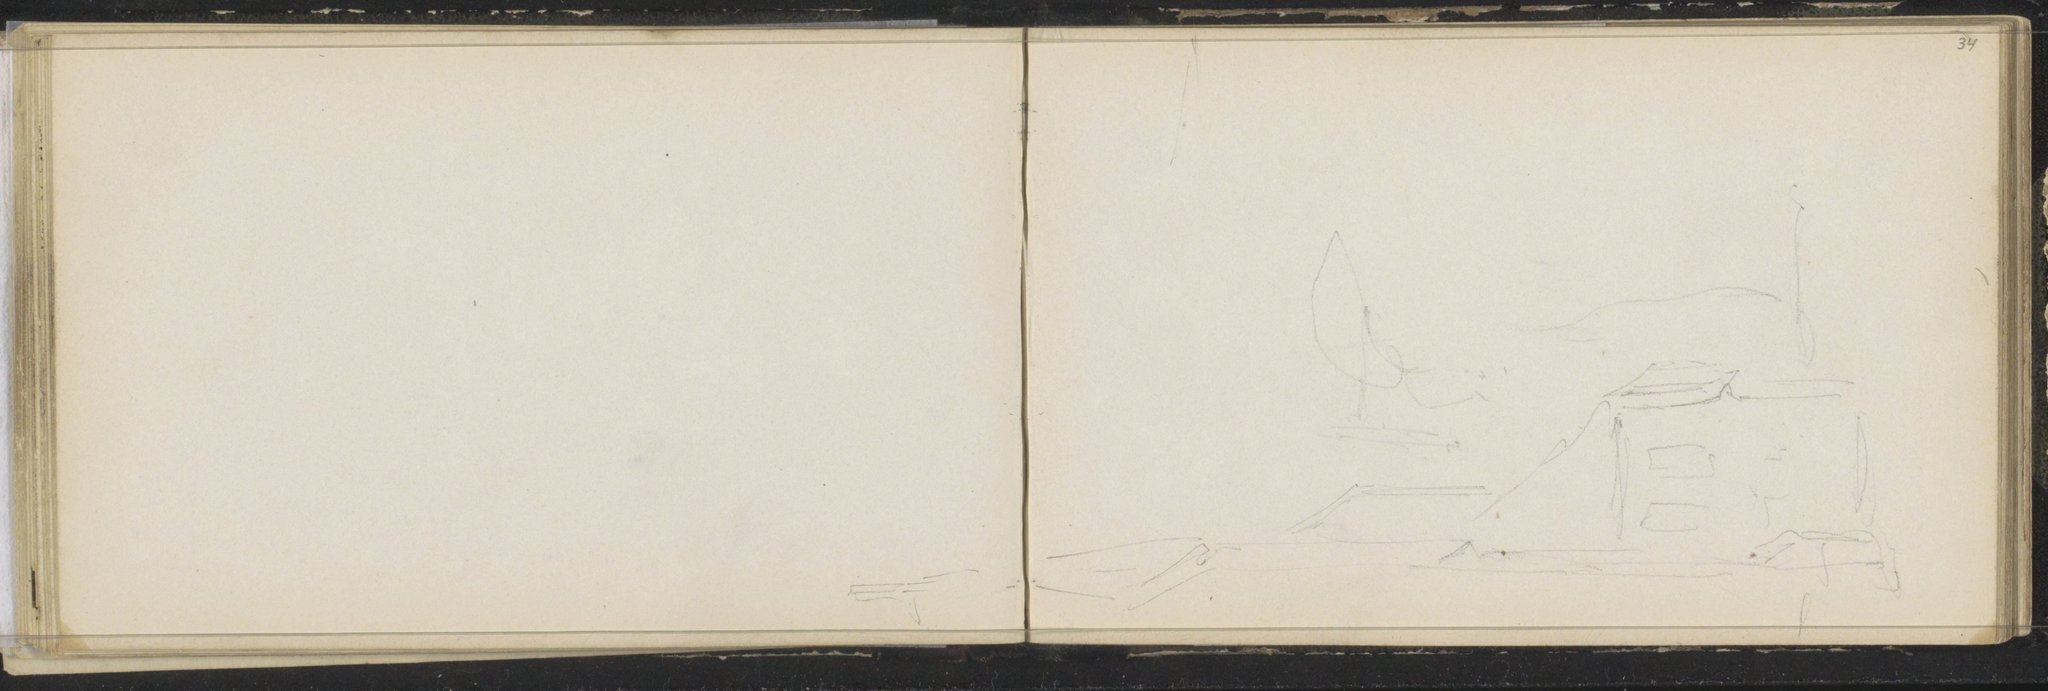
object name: sketchbook leaf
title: Gezicht op gebouwen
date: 1863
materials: paper, pencil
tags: urban housing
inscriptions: annotation: ‘dito voor honden’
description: Gezicht op gebouwen. Blad 33 verso en blad 34 recto uit een schetsboek met 55 bladen vervaardigd op de Veluwe en in Noord-Duitsland.